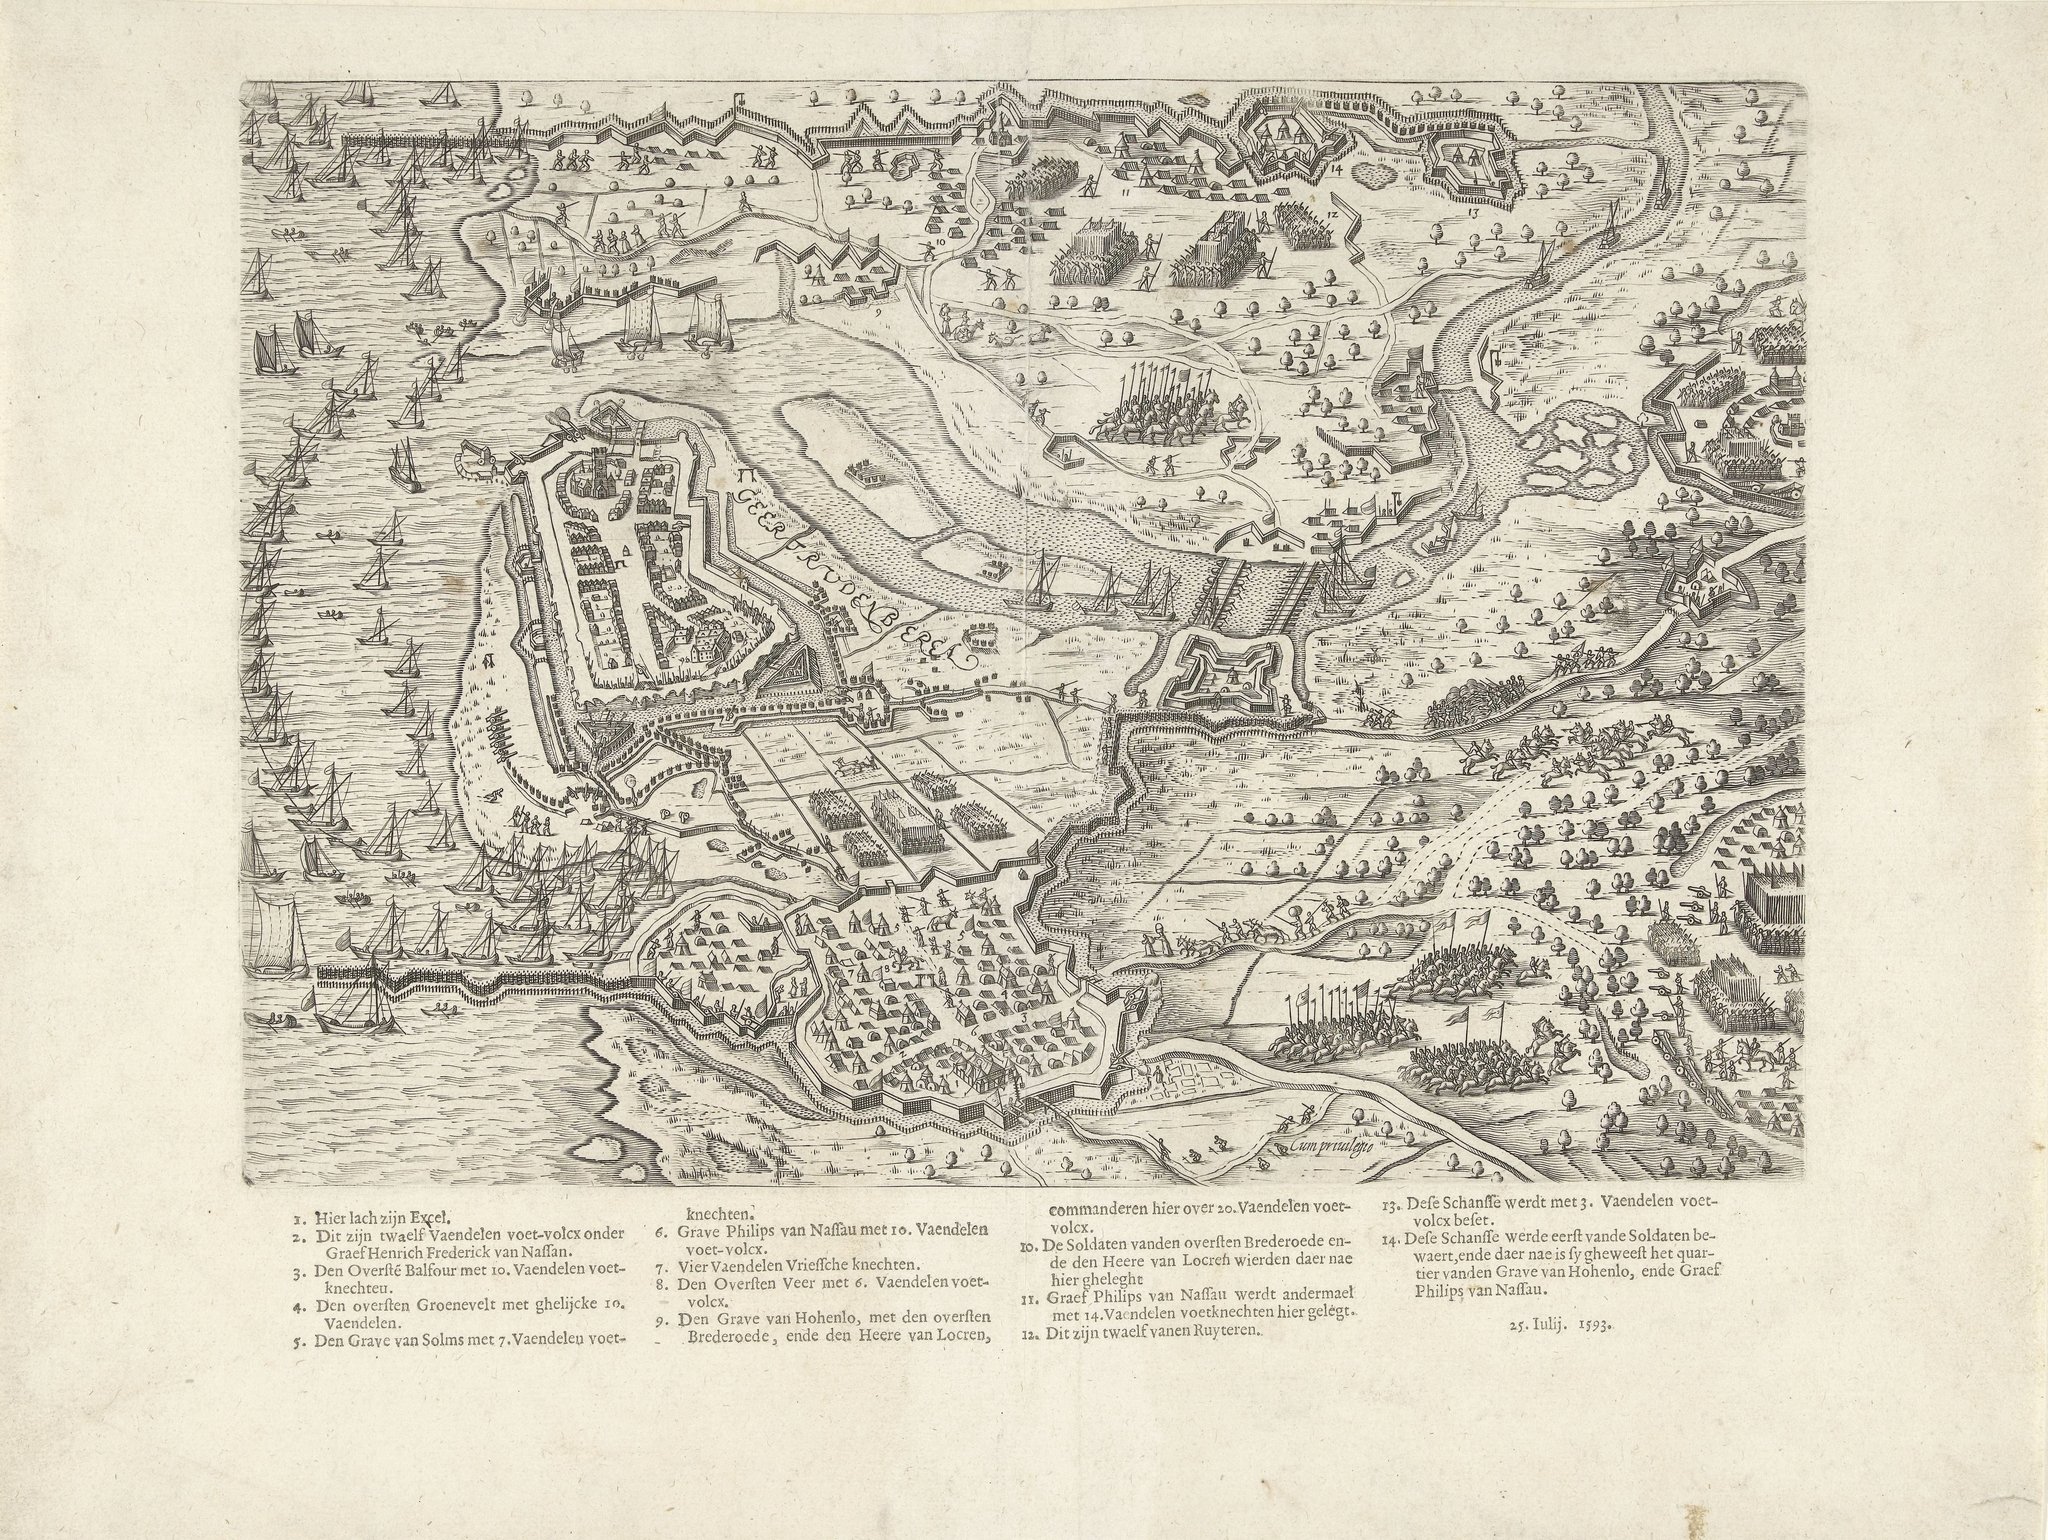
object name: print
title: Beleg van Geertruidenberg, 1593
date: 1600-1601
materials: paper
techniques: engraving, letterpress printing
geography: northern netherlands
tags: the hague, maurice (prince of orange), maps of separate countries or regions, siege, position war, geertruidenberg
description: Prent gebruikt in: Orlers, Jan Jansz. Den Nassauschen Lauren-Crans: Beschrijvinghe ende af-beeldinge van alle de victorien (...) die Godt Almachtich de (...) Staten der Vereenichde Neder-landen verleent heeft, deur het wijs ende clouck beleyt des Hooch-ghebooren Fursts Maurits van Nassau. Leiden: Jan Jansz. Orlers en Henrick Lodewijcxsoon van Haestens, 1610, fol. 90/91. Zonder deze tekst onder de afbeelding is de prent later ook nog gebruikt in: Orlers, Jan Jansz. Les lauriers de Nassau: Description & representation de toutes les victoires […] lesquelles Dieu a octroiees aux […] Estats des Provinces Vnies du Païs-Bas, souz la conduite & gouuernement de Son Excellence, le prince Mavrice de Nassav. Leiden: Jan Jansz. Orlers en Henrick Lodewijcxsoon van Haestens, 1612, fol. 108/109.